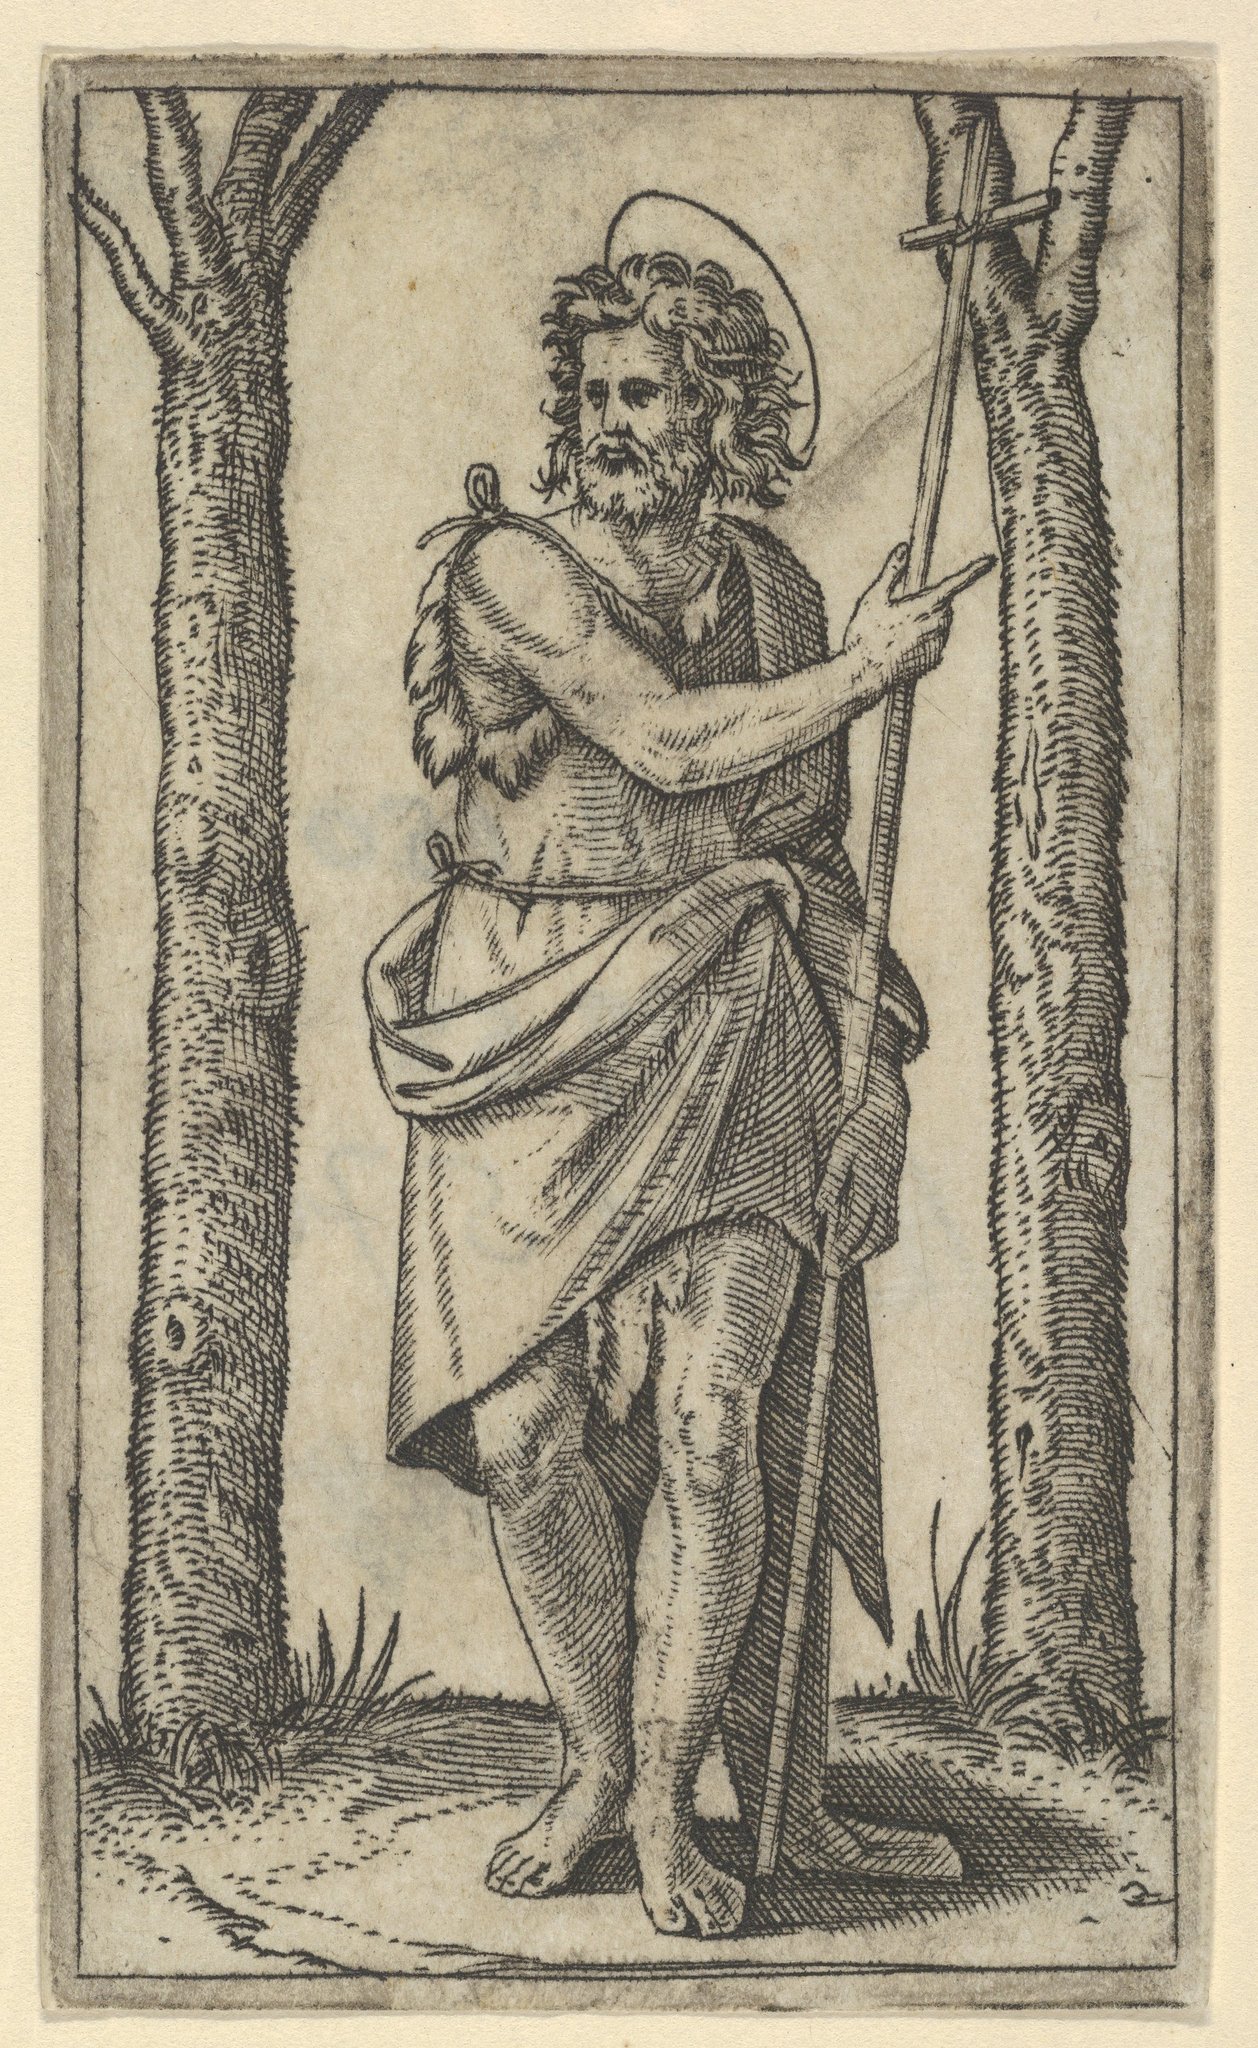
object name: print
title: John the Baptist holding a staff, from "Piccoli Santi" (Small Saints)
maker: marcantonio raimondi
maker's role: artist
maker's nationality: italian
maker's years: 1475-1534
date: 1500-1527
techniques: engraving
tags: trees,saint john the baptist